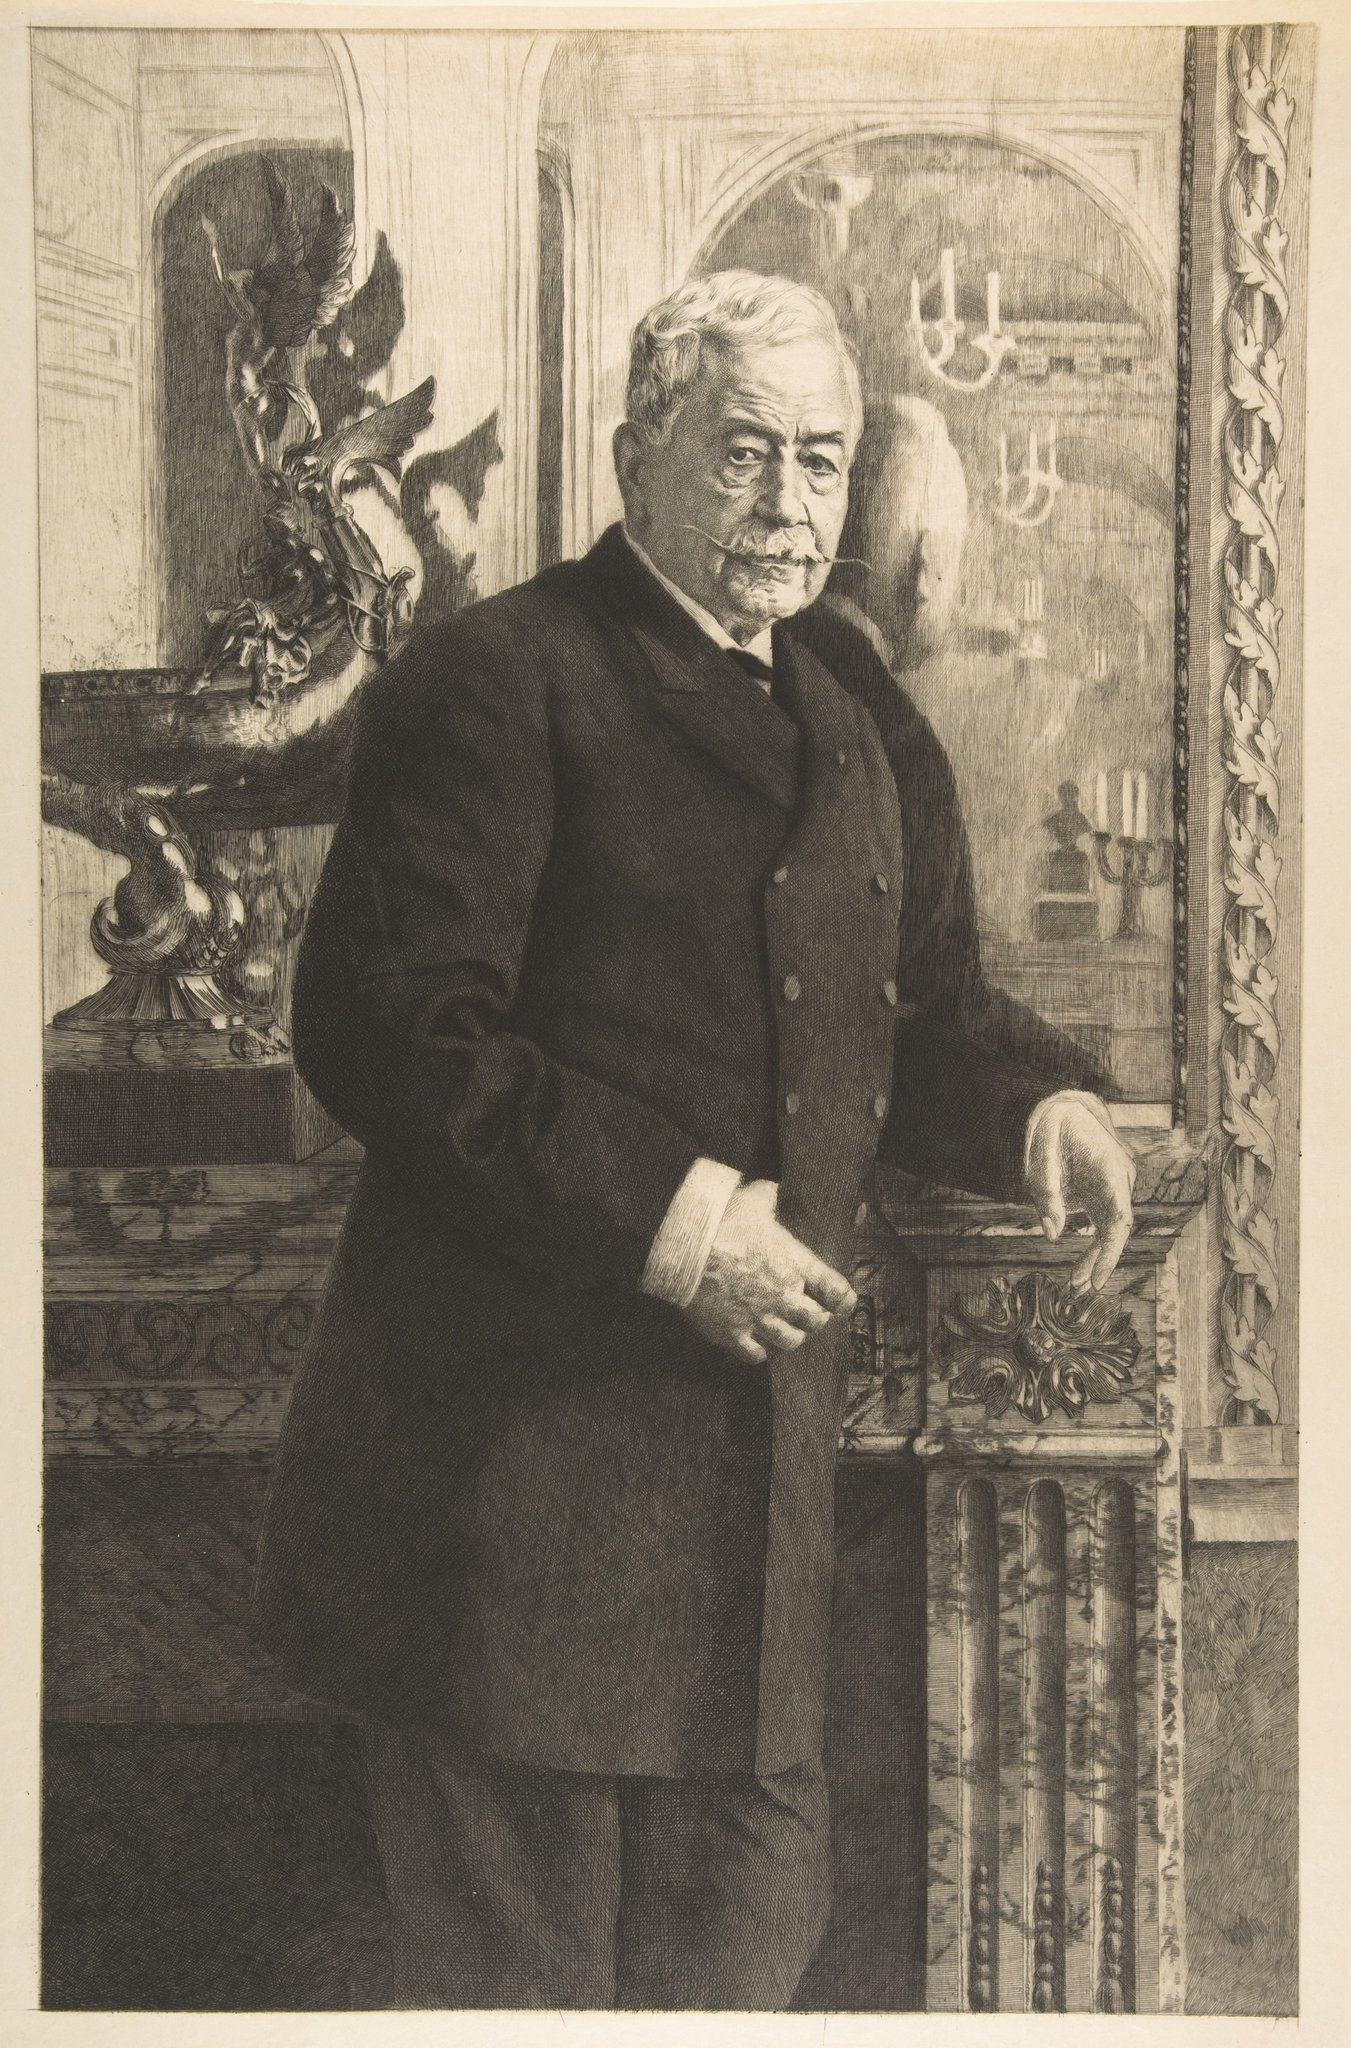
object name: print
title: Portrait of Ferdinand Lesseps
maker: anonymous, french, 19th century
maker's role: artist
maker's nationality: french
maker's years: 1800-1900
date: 1850-1914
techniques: etching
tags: men,portraits